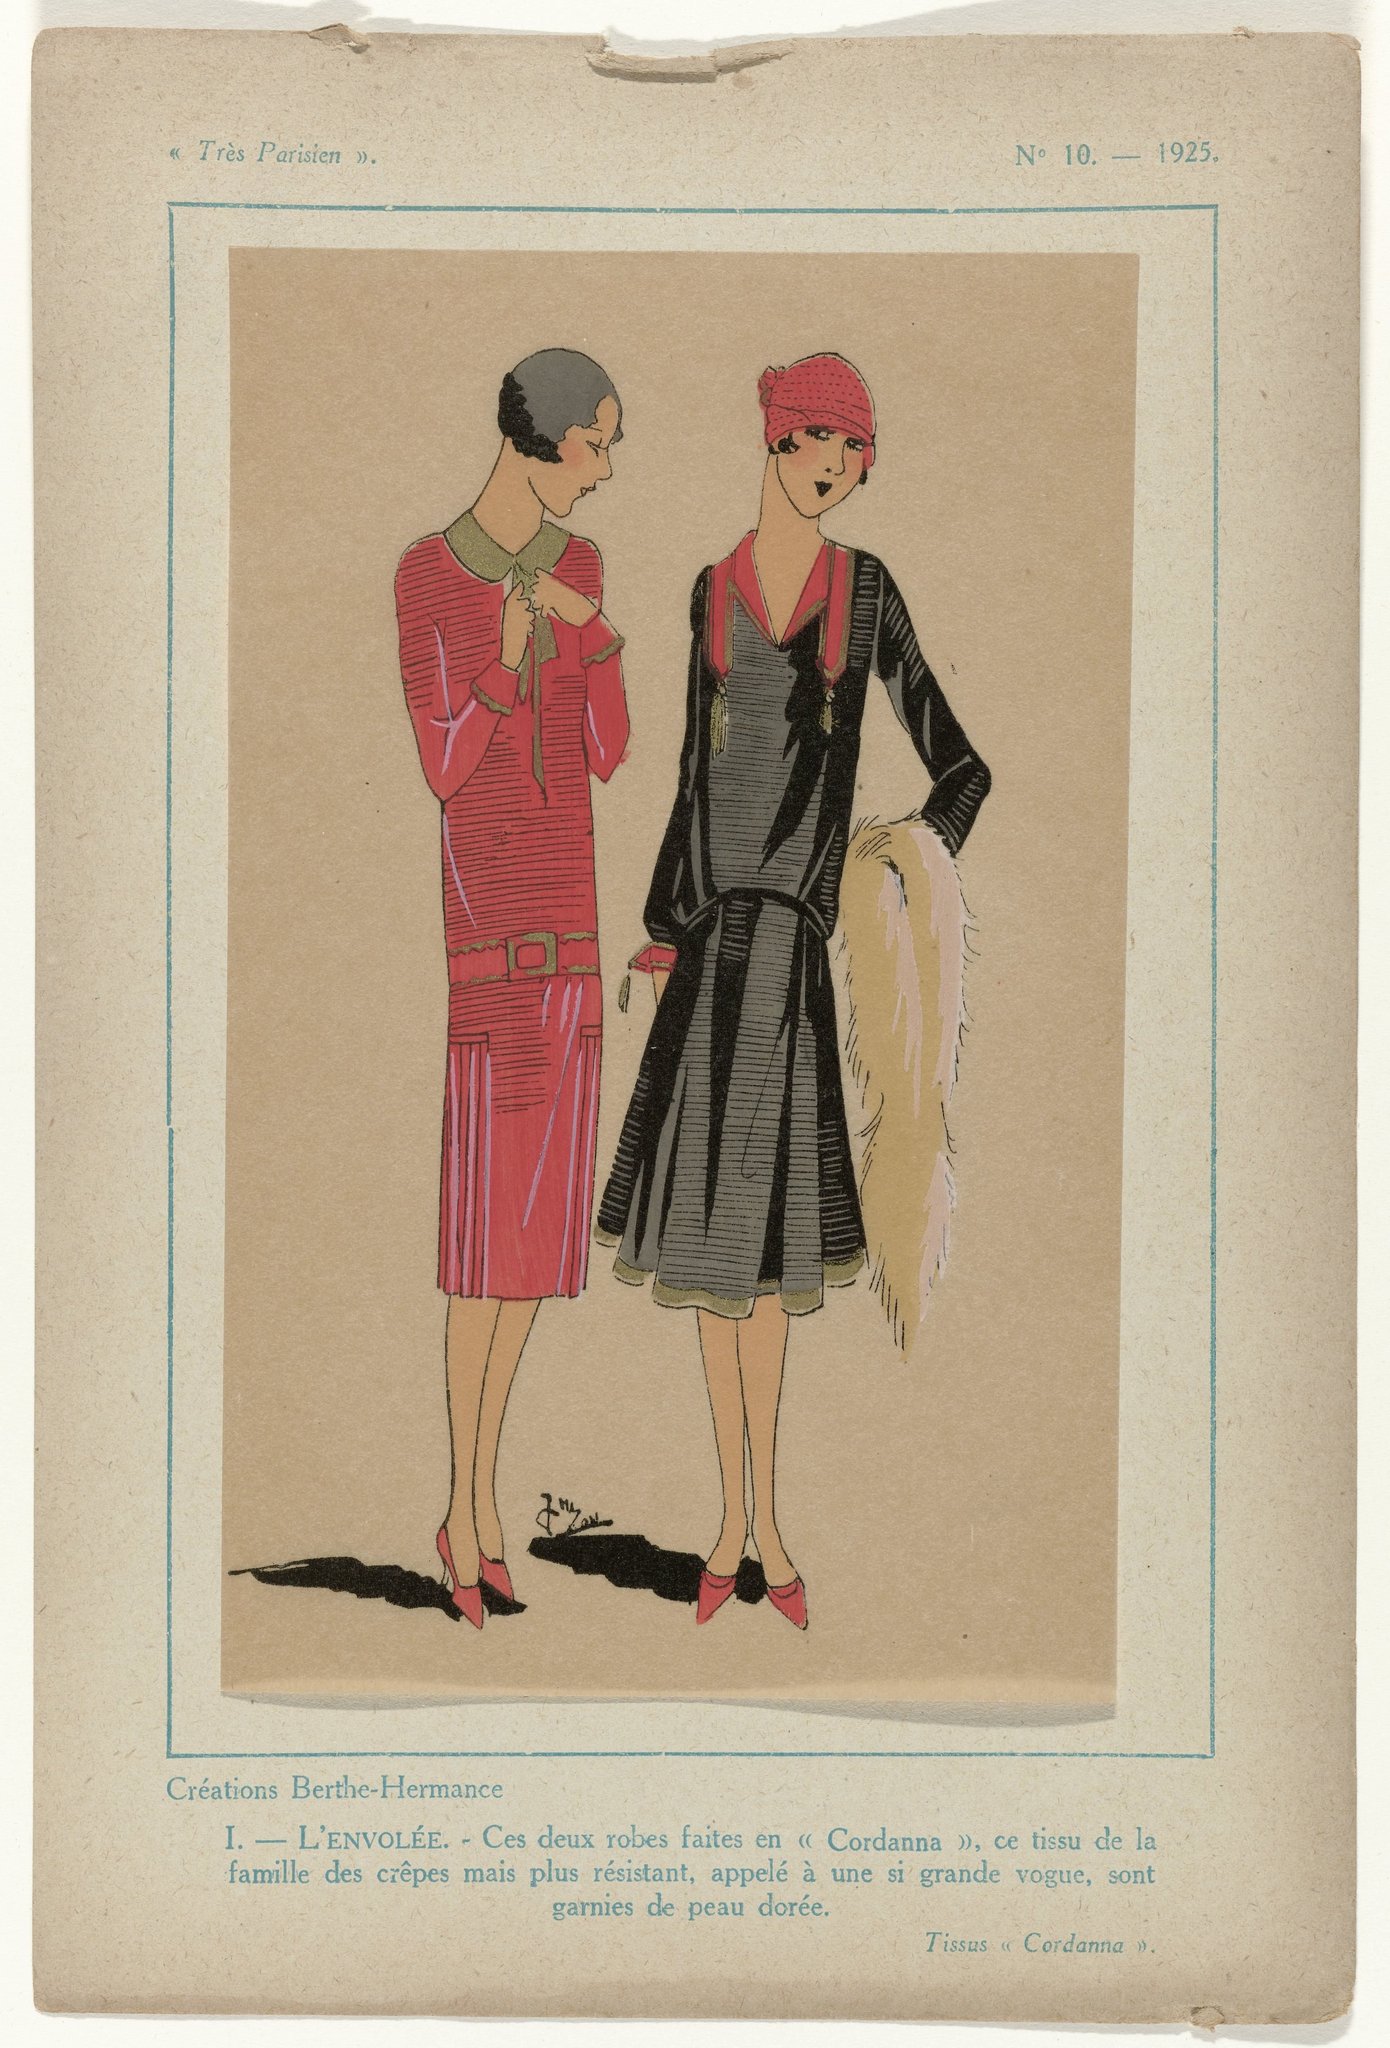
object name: fashion print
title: Très Parisien, 1925, No. 10, Pl. 1: Créations Berthe Hermance - L'ENVOLÉE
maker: g-p. joumard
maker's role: publisher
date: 1925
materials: paper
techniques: hand coloring, letterpress printing, lithography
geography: paris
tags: dress, gown: day dress (+ women's clothes), neck-gear ~ clothing (shawl) (+ women's clothes), fashion plates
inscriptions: caption: ‘1. L'ENVOLÉE. - Ces deux robes faites en "Cordanna", ce tissu de la famille des crêpes mais plûs résistant, appelé à une si grande vogue, sont garnies de peau dorée.’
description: Twee japonnen van "Cordanna", een stof die, volgens het onderschrift, op dat moment in de mode was. (familie van de crêpe, maar steviger) Prent uit het modetijdschrift Très Parisien...La Mode, Le Chic, L'Élégance (1920-1936)